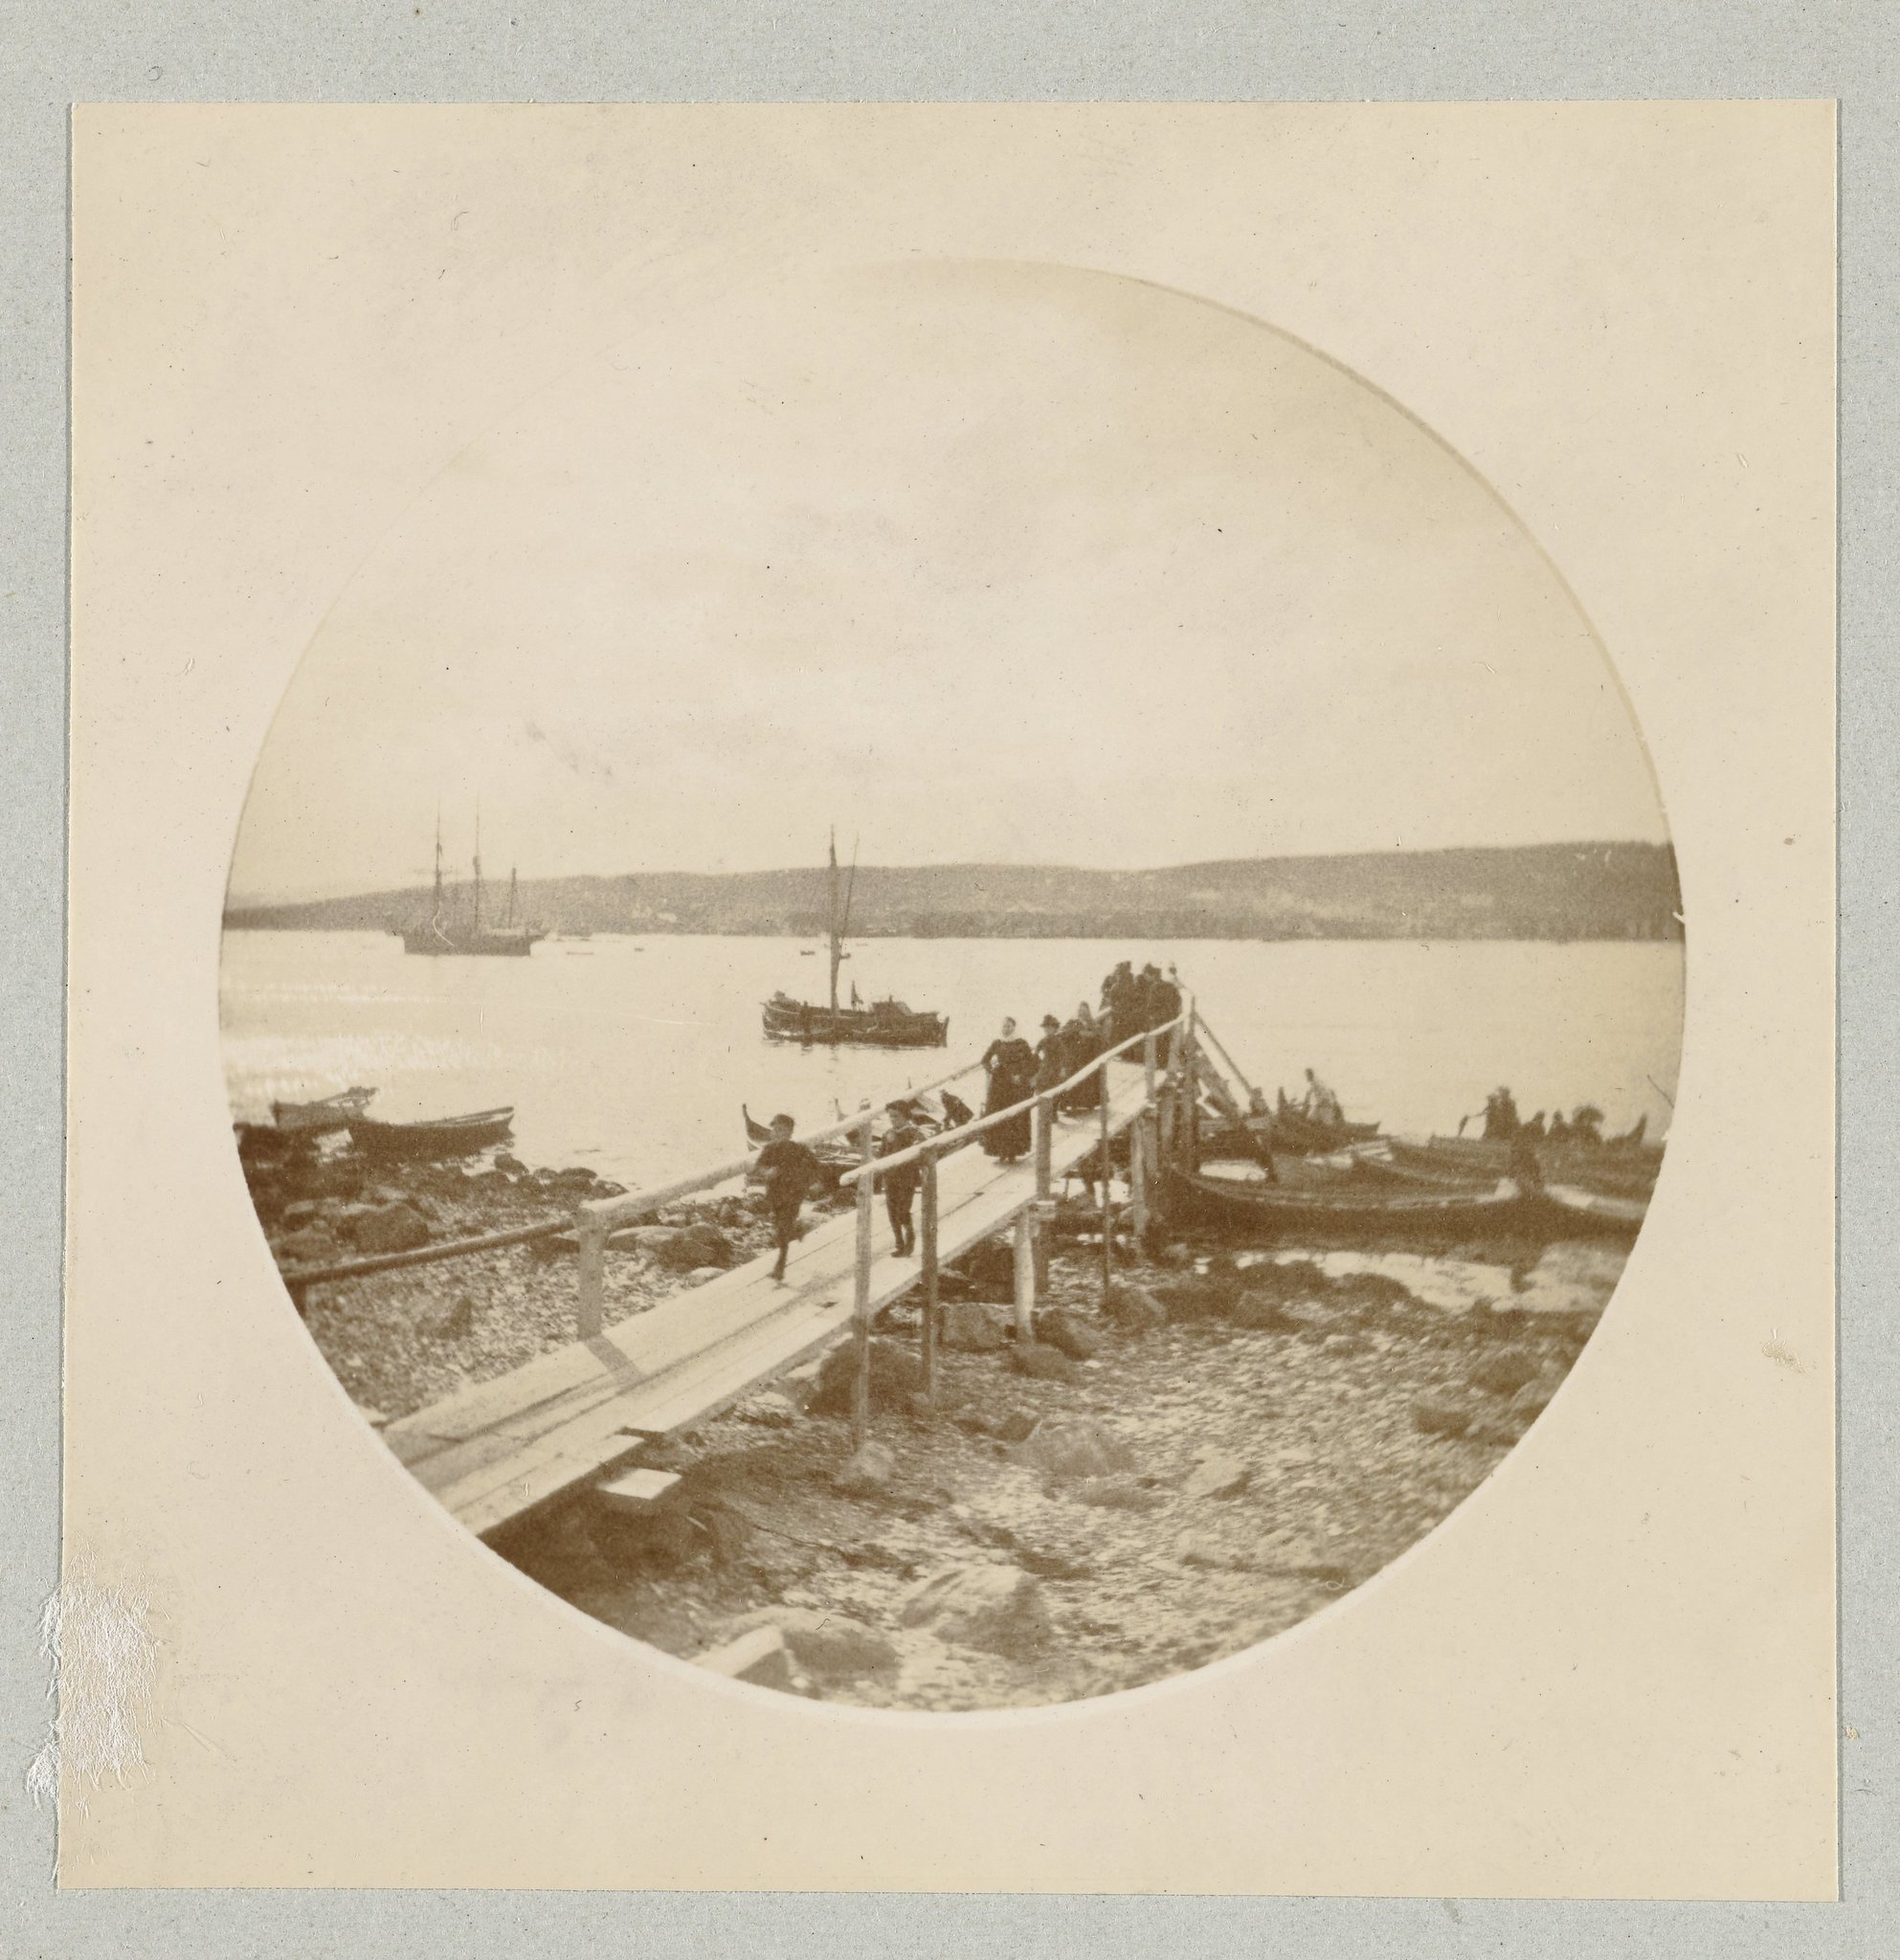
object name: photograph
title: Mensen op een stijger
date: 1807-1889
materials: cardboard, paper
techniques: gelatin silver print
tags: norway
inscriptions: number: ‘31’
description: De afdruk van de foto is rond, het papier vierkant.foto gemaakt met Nr. 1 Kodak Camera